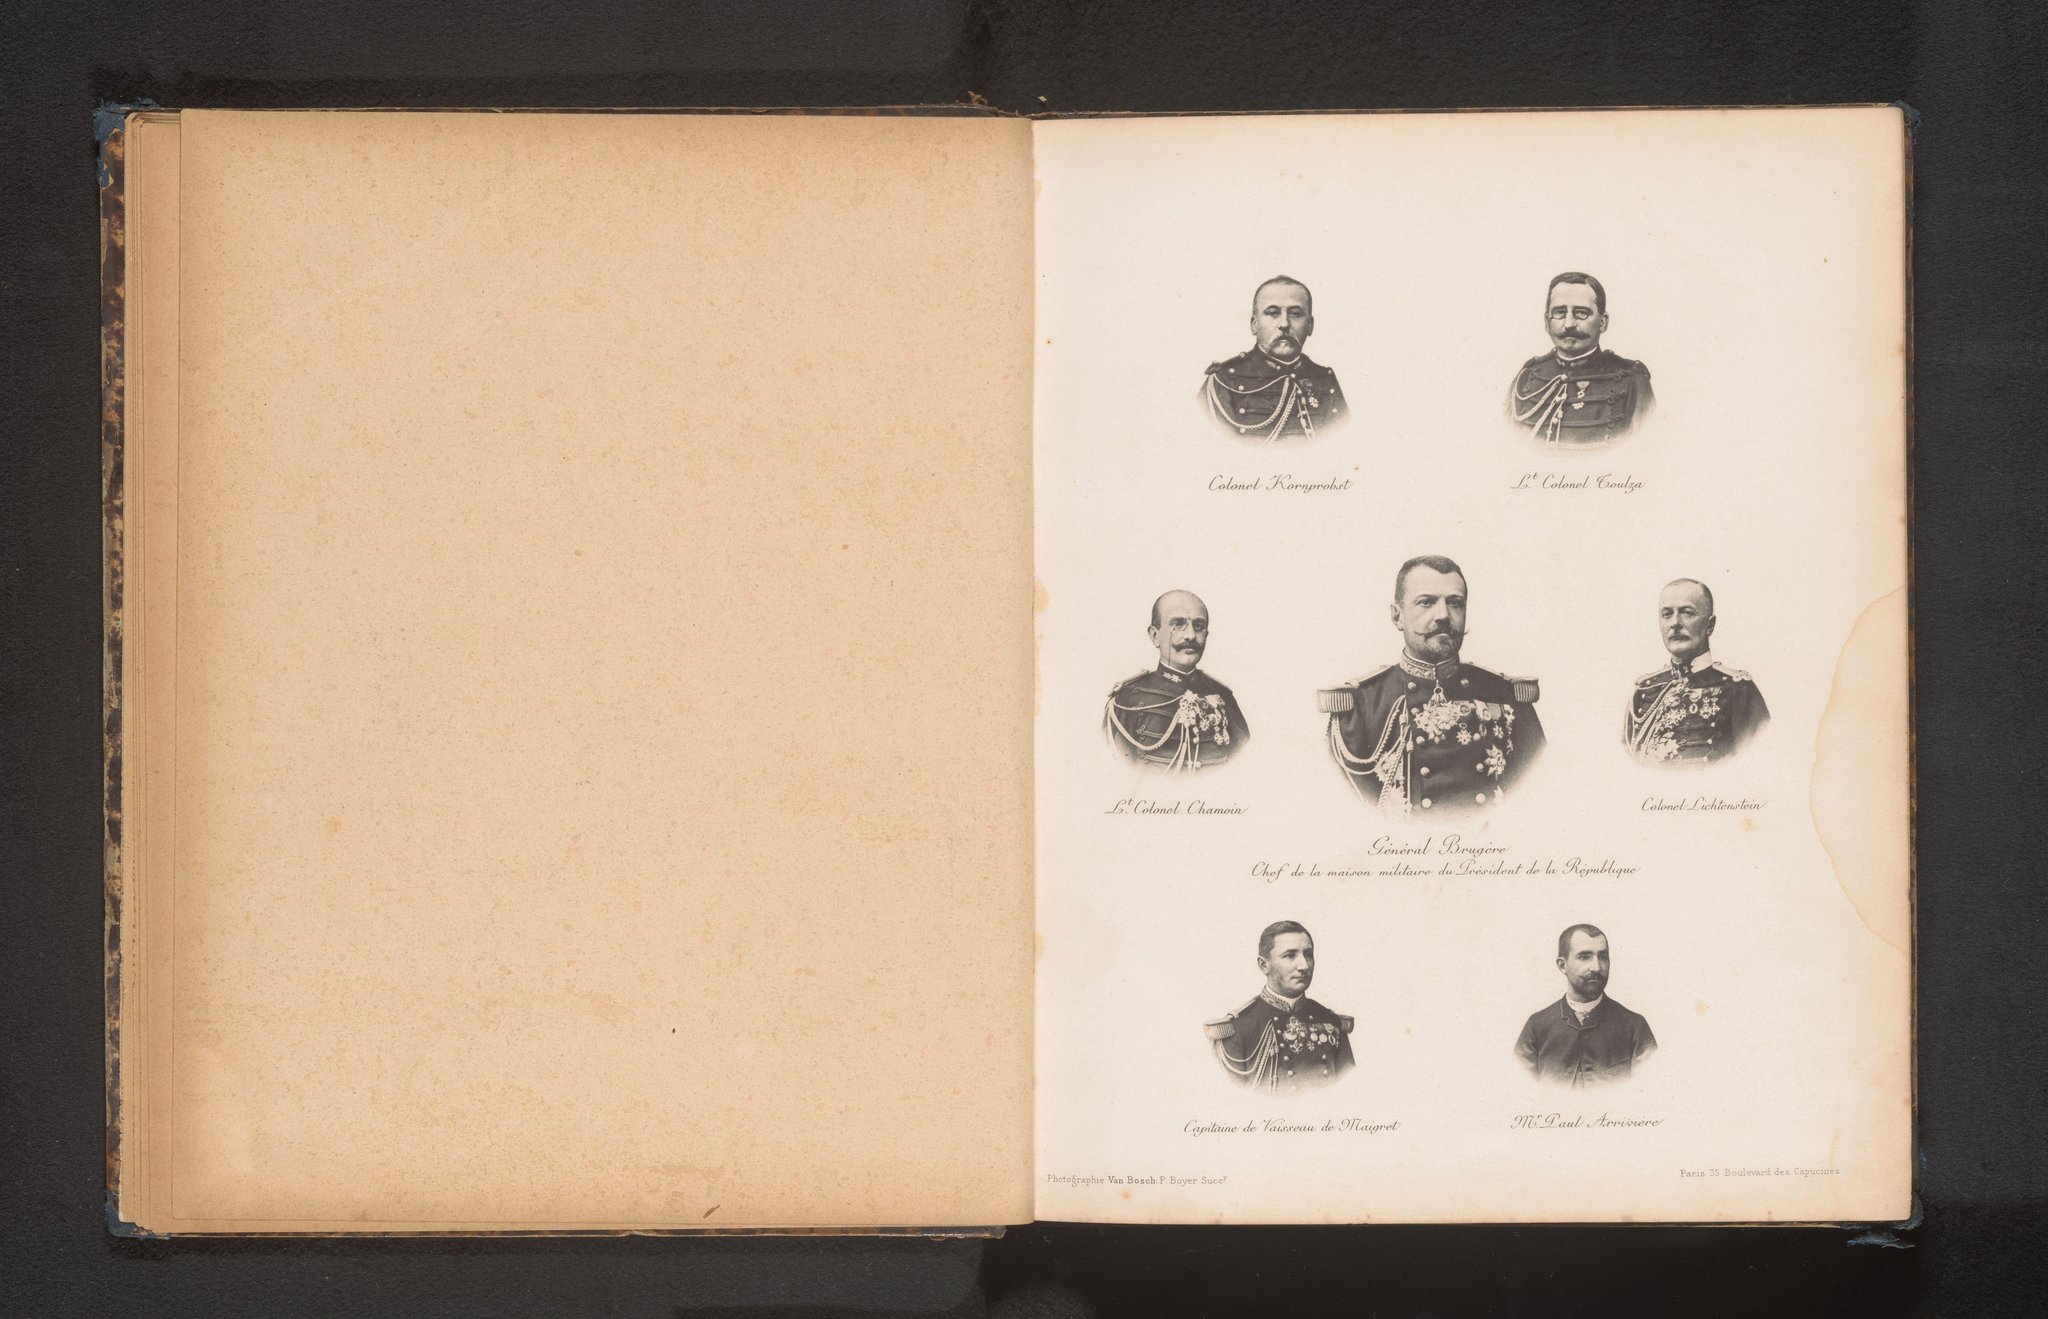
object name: page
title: Zeven portretten van legeraanvoerders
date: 1885-1890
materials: paper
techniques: photoaquatint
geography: france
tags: ranks in the army, commander-in-chief, general, marshal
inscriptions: inscription: ‘Colonel Kornprobst (...) Mr Paul Arrivière’, inscription: ‘Paris 35 Boulevard des Capucines’